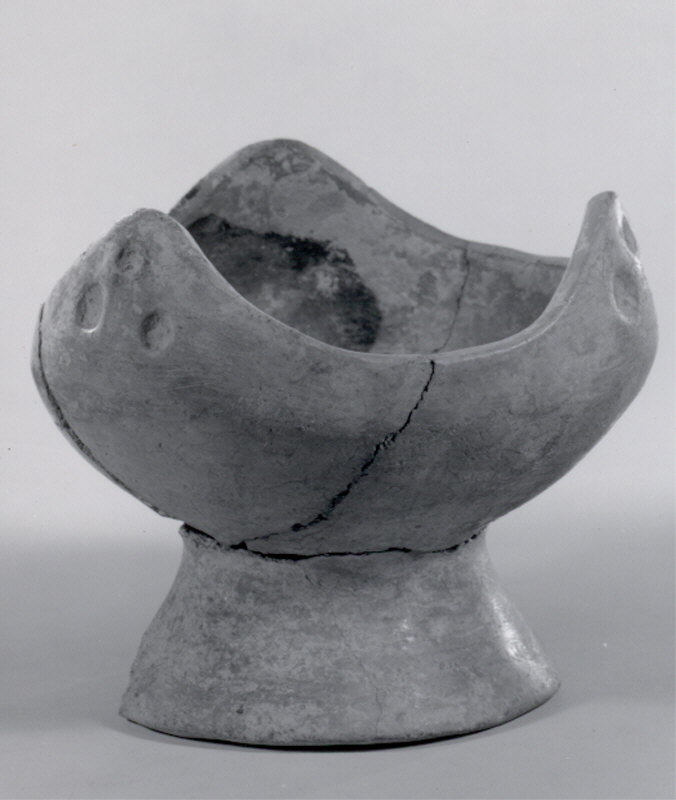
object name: brazier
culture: iranian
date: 900-801 BCE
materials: ceramic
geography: iran